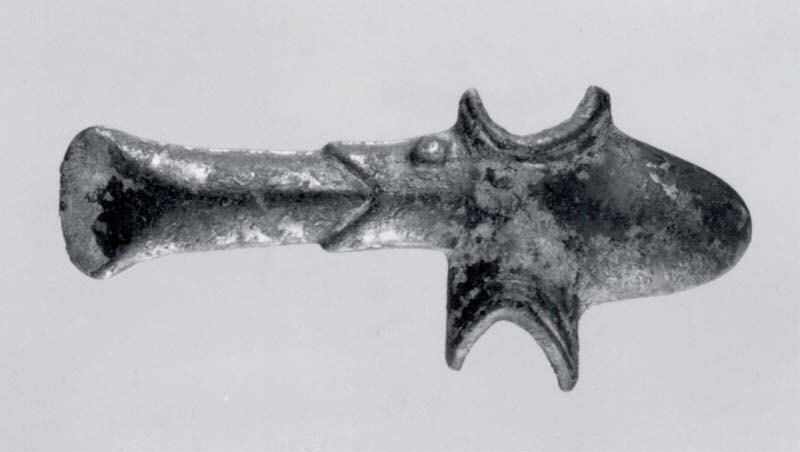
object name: axe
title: Axe head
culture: iranian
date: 2350-2150 BCE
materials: bronze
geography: iran or mesopotamia